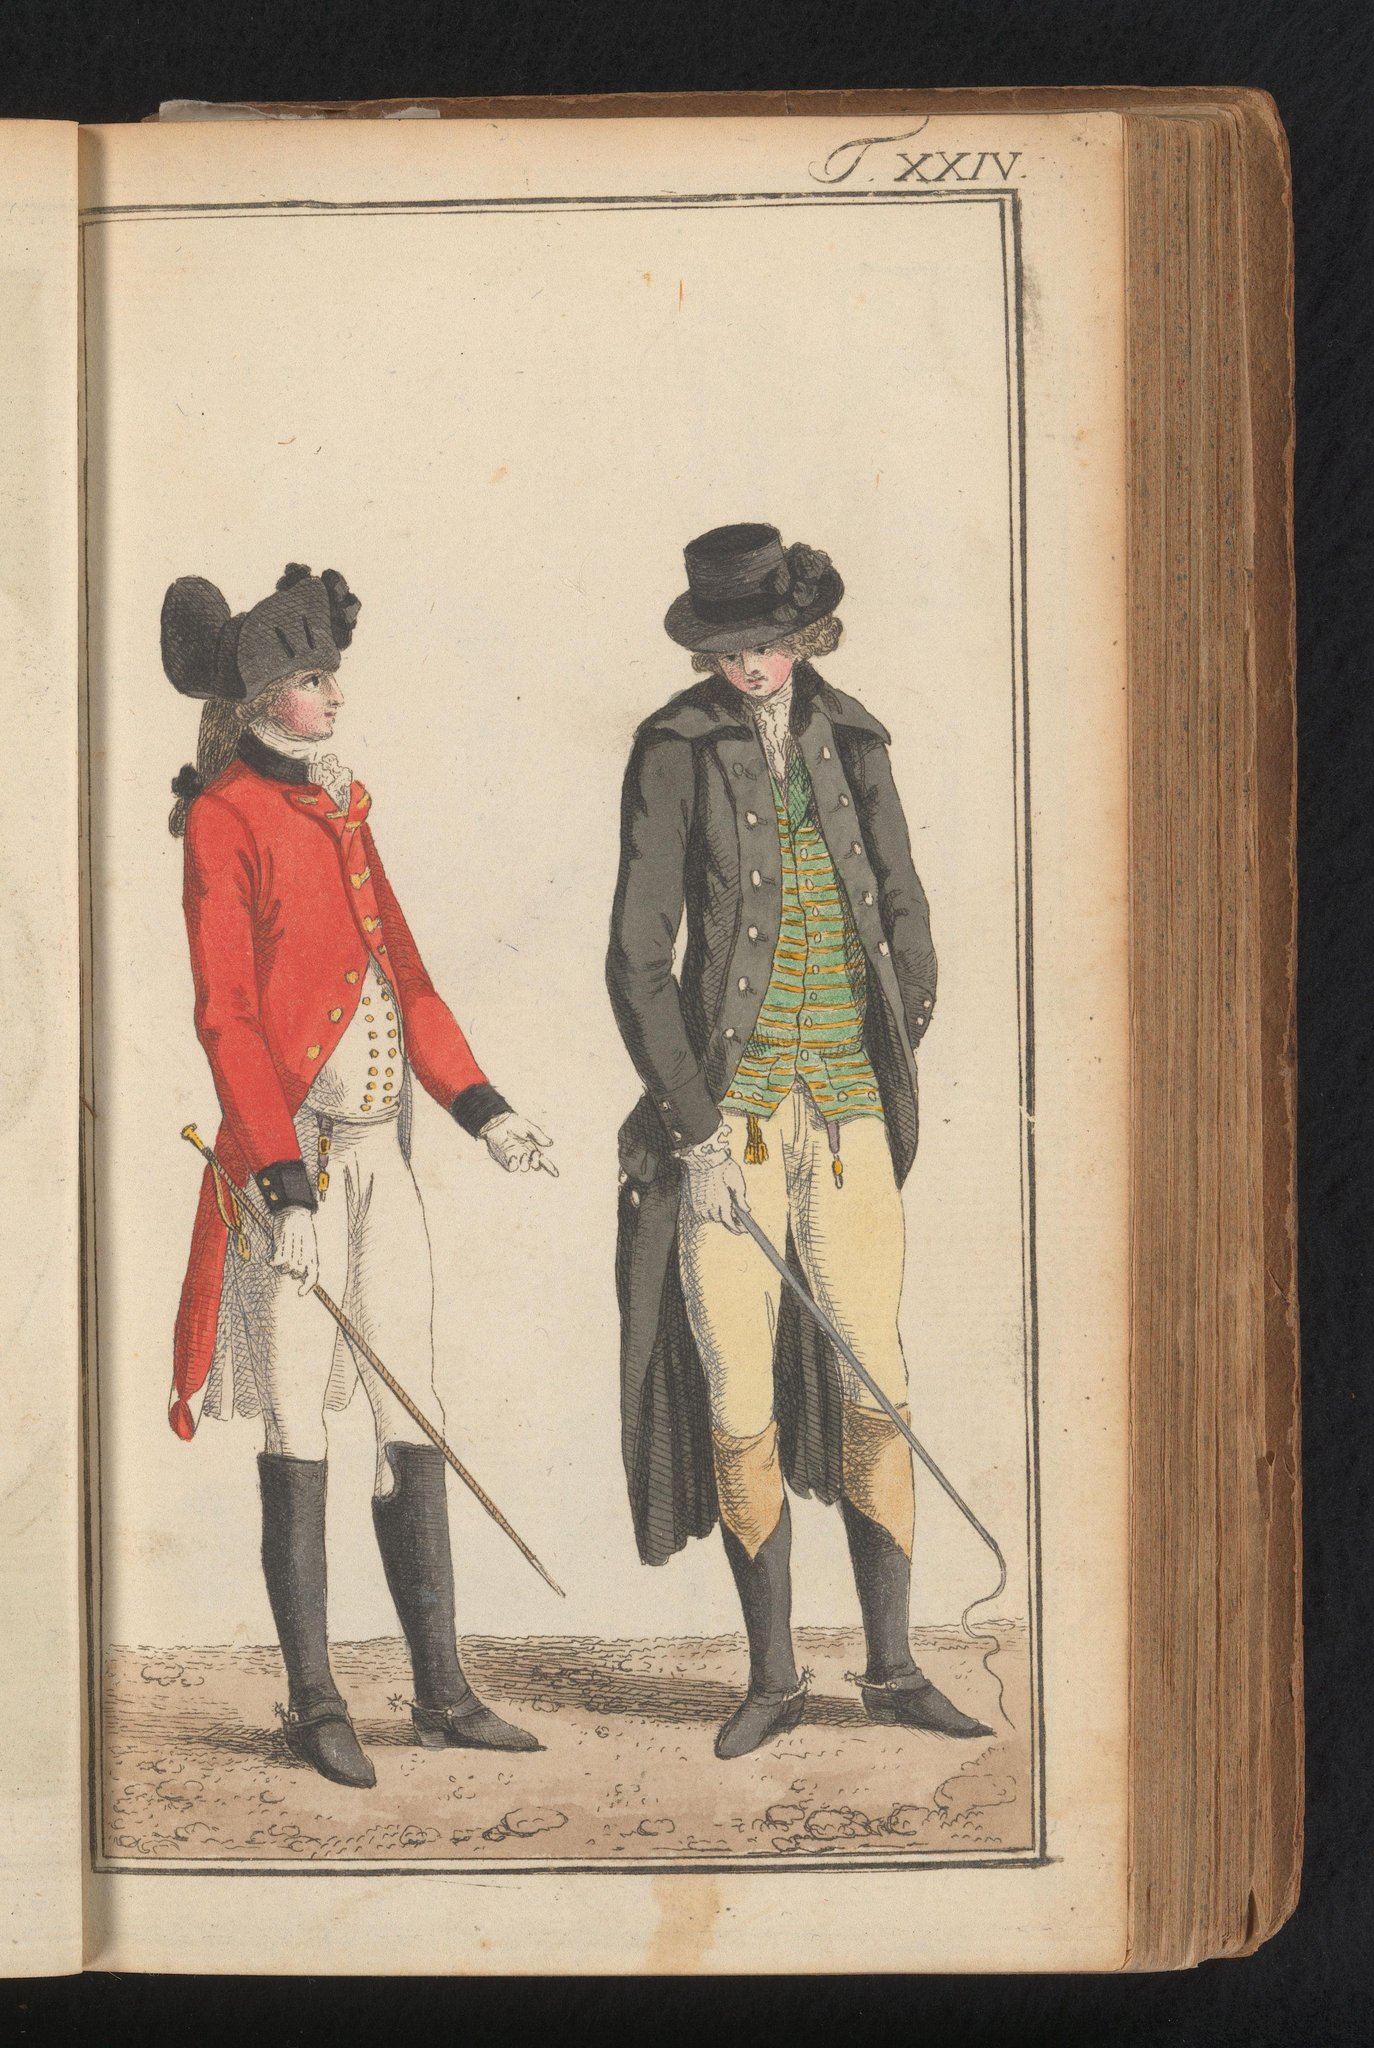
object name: fashion print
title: Journal des Luxus und der Moden 1786, Band I, T. 24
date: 1786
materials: paper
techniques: etching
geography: weimar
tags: clothing for the upper part of the body (vest) (+ men's clothes), head-gear, coat (frac) (+ men's clothes), head-gear: hat (+ men's clothes), fashion plates, clothes, costume (+ men's clothes), trousers, breeches, etc. (breeches) (+ men's clothes), boots (+ men's clothes), walking-stick, staff, cane (+ men's clothes), ensembles of pieces of clothing (riding costume) (+ men's clothes)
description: De kleding van de Franse en de Duitse ruiter worden met elkaar vergeleken. De Duitse ruiter (links) is elegant en kan zich na het paardrijden in goed gezelschap vertonen. Op het hoofd een Chapeau à l'Androsman (in de tekst niet als zodanig benoemd) Hij is gekleed in een rode Berlijnse frak die op de borst over elkaar valt en met een paar knopen is gesloten. Daaronder een wit gilet en een "Hongaarse' rijbroek van wit gemsleer. Handschoenen van wit gemsleer. Chatelaine met één horloge. Zwarte rijlaarzen met zilveren Engelse sporen. Rijzweep in de hand. De Franse ruiter is 'verkeerd gekleed'. Als fouten worden genoemd: een te lange ruitersjas, zonder enige elegantie. Vest dat ....... Chatelaines met twee horloges (één is genoeg) Spits gesneden omslagen van rijlaarzen. .............................................................(lees pp. 287 e.v.)Prent uit het modetijdschrift Journal des Luxus und der Moden, uitgegeven door Friedrich Justin Bertuch en Georg Melchior Kraus, Weimar, 1786-1826.